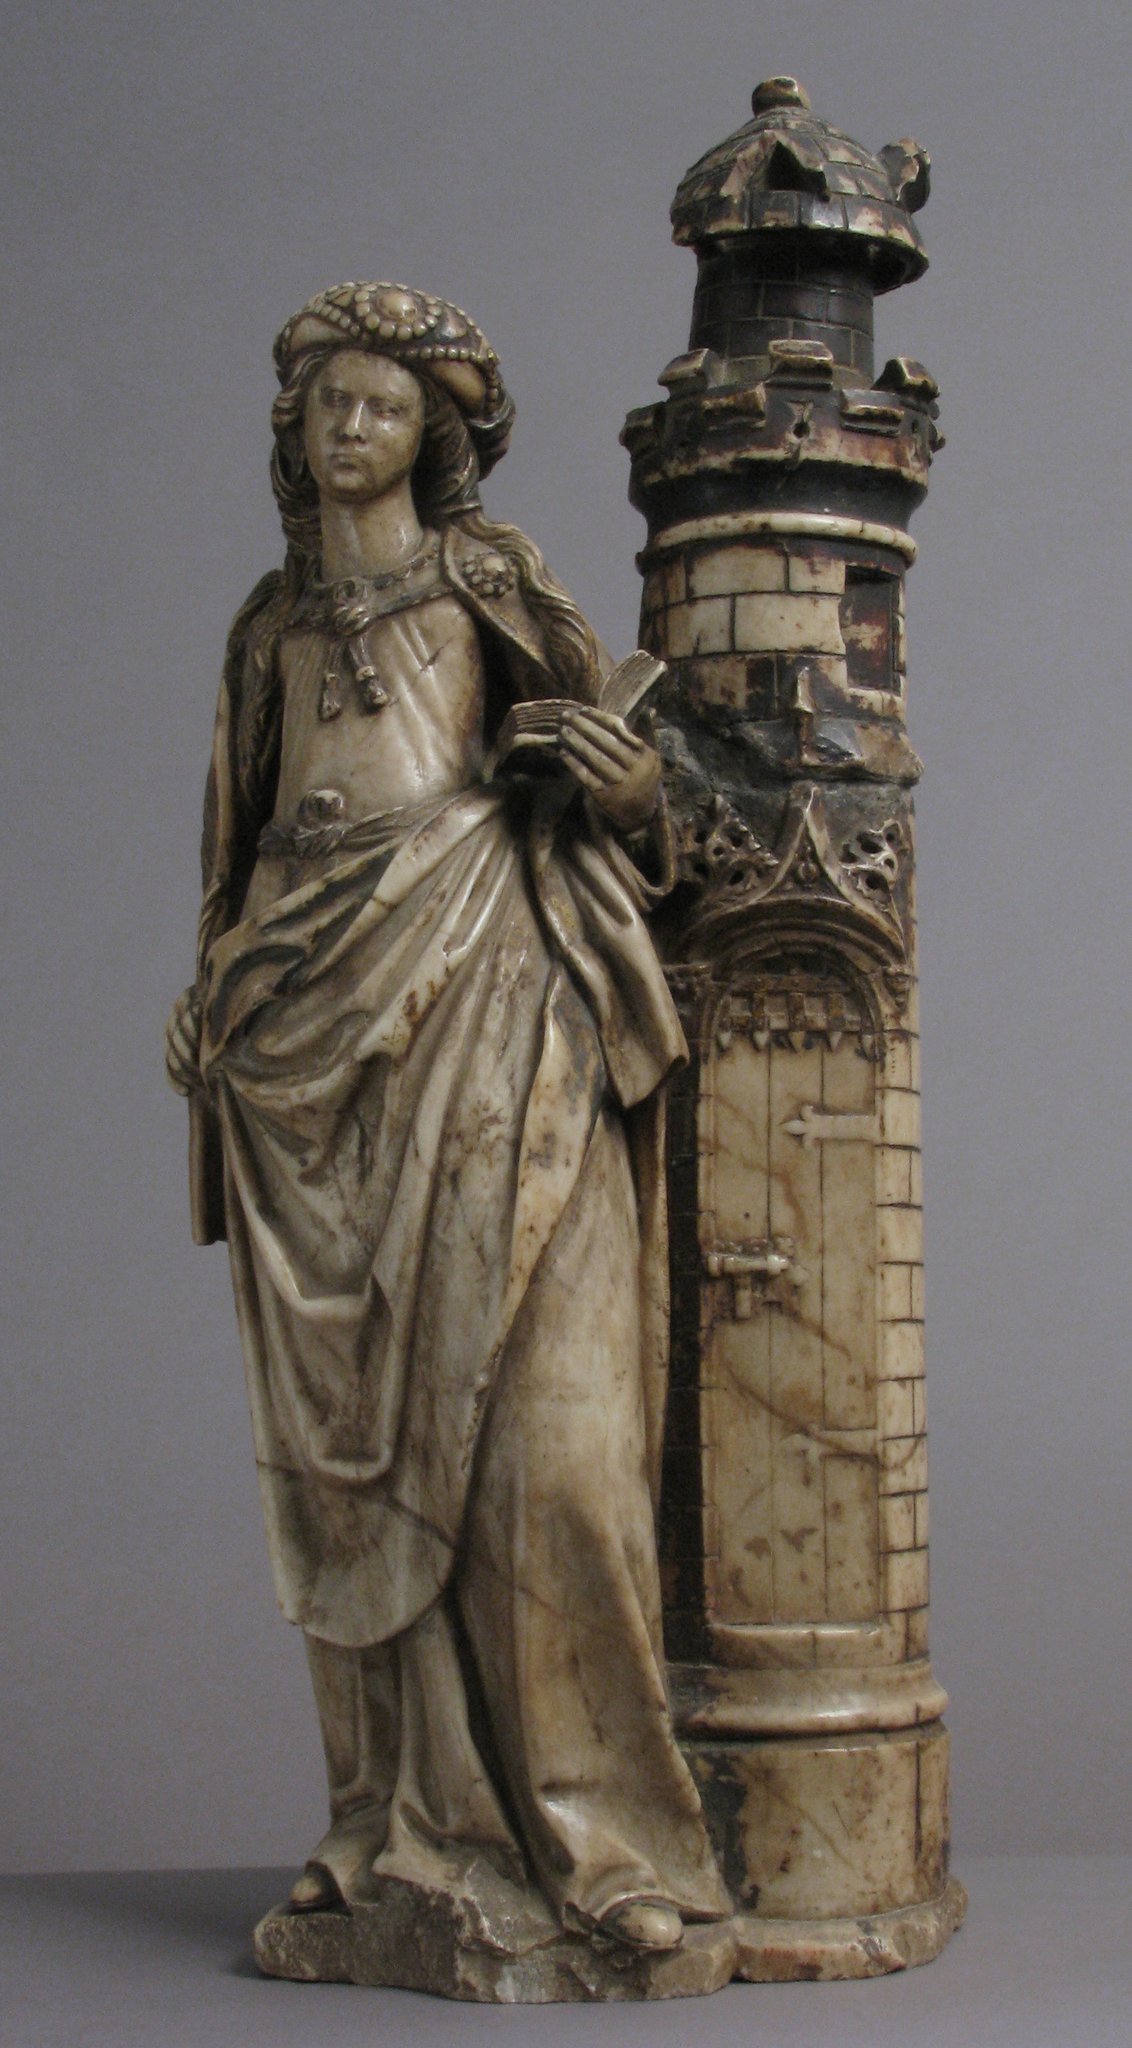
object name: statuette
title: Saint Barbara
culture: french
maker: school of troyes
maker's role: artist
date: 1501-1600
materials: marble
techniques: gilding, polychromy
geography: france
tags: women